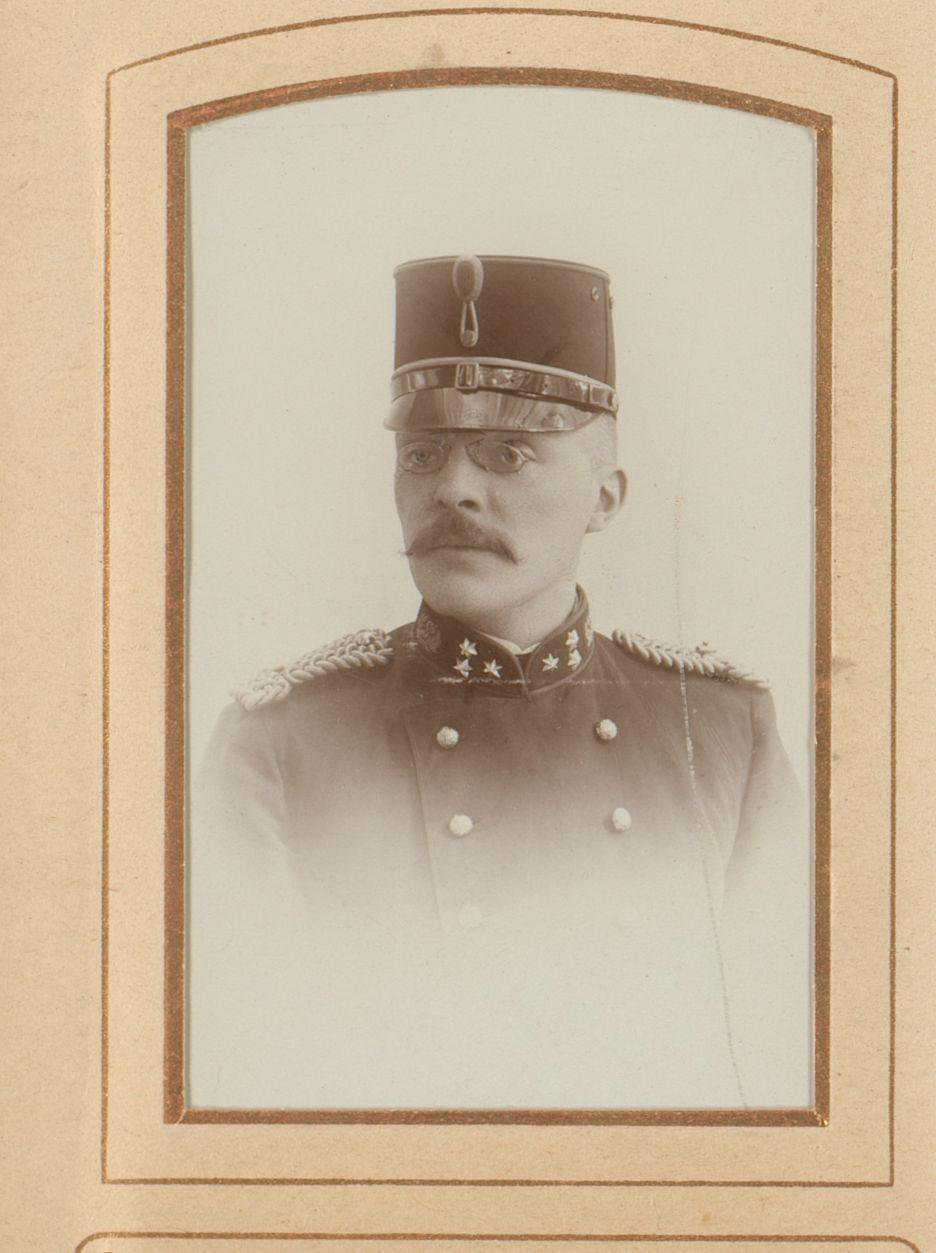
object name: album leaf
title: Portret van een man in uniform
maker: Anonymous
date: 1890-1920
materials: cardboard, photographic support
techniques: collodion silver print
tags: historical persons, (military) uniforms